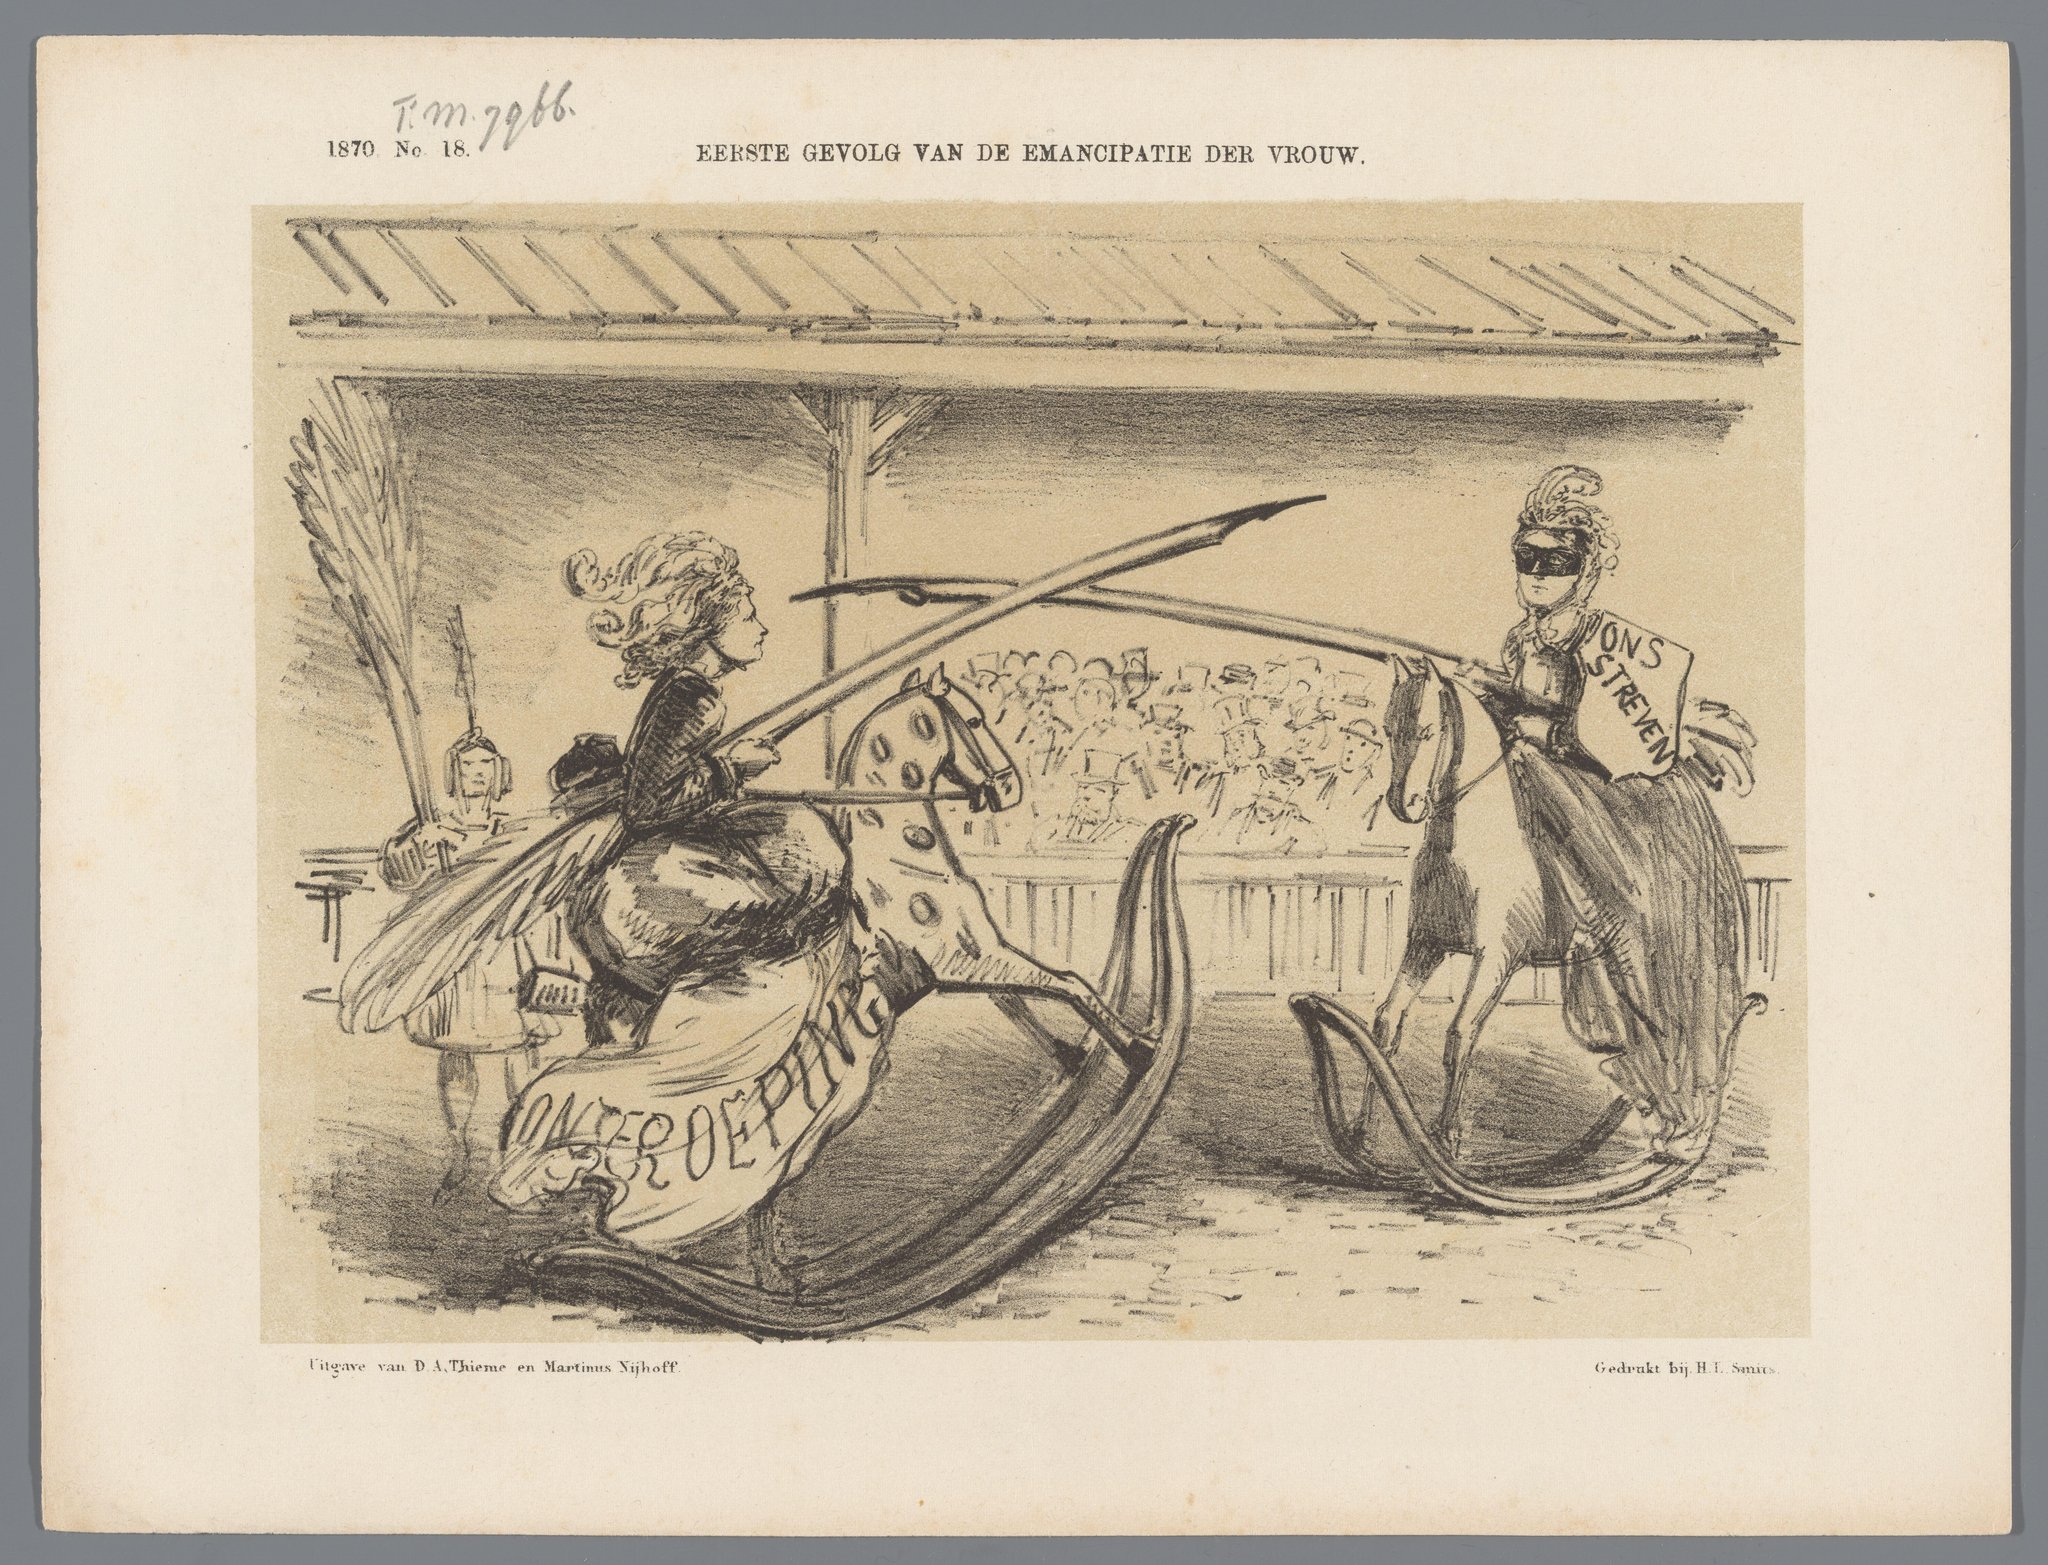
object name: cartoon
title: Spotprent op strijd tussen vrouwentijdschriften, 1870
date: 1870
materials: paper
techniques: tone lithography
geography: netherlands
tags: painter, sculptor, christina elizabeth perk, weekly, monthly, magazine, etc., hobby-horse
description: Spotprent op strijd tussen twee vrouwentijdschriften opgericht in 1870. Steekspel tussen twee vrouwen op hobbelpaarden. Links Betsy Perk van 'Onze Roeping', rechts Mej. De Goeije van 'Ons Streven'. Plaat verschenen bij het weekblad De Nederlandsche Spectator, nr. 18, 1870.